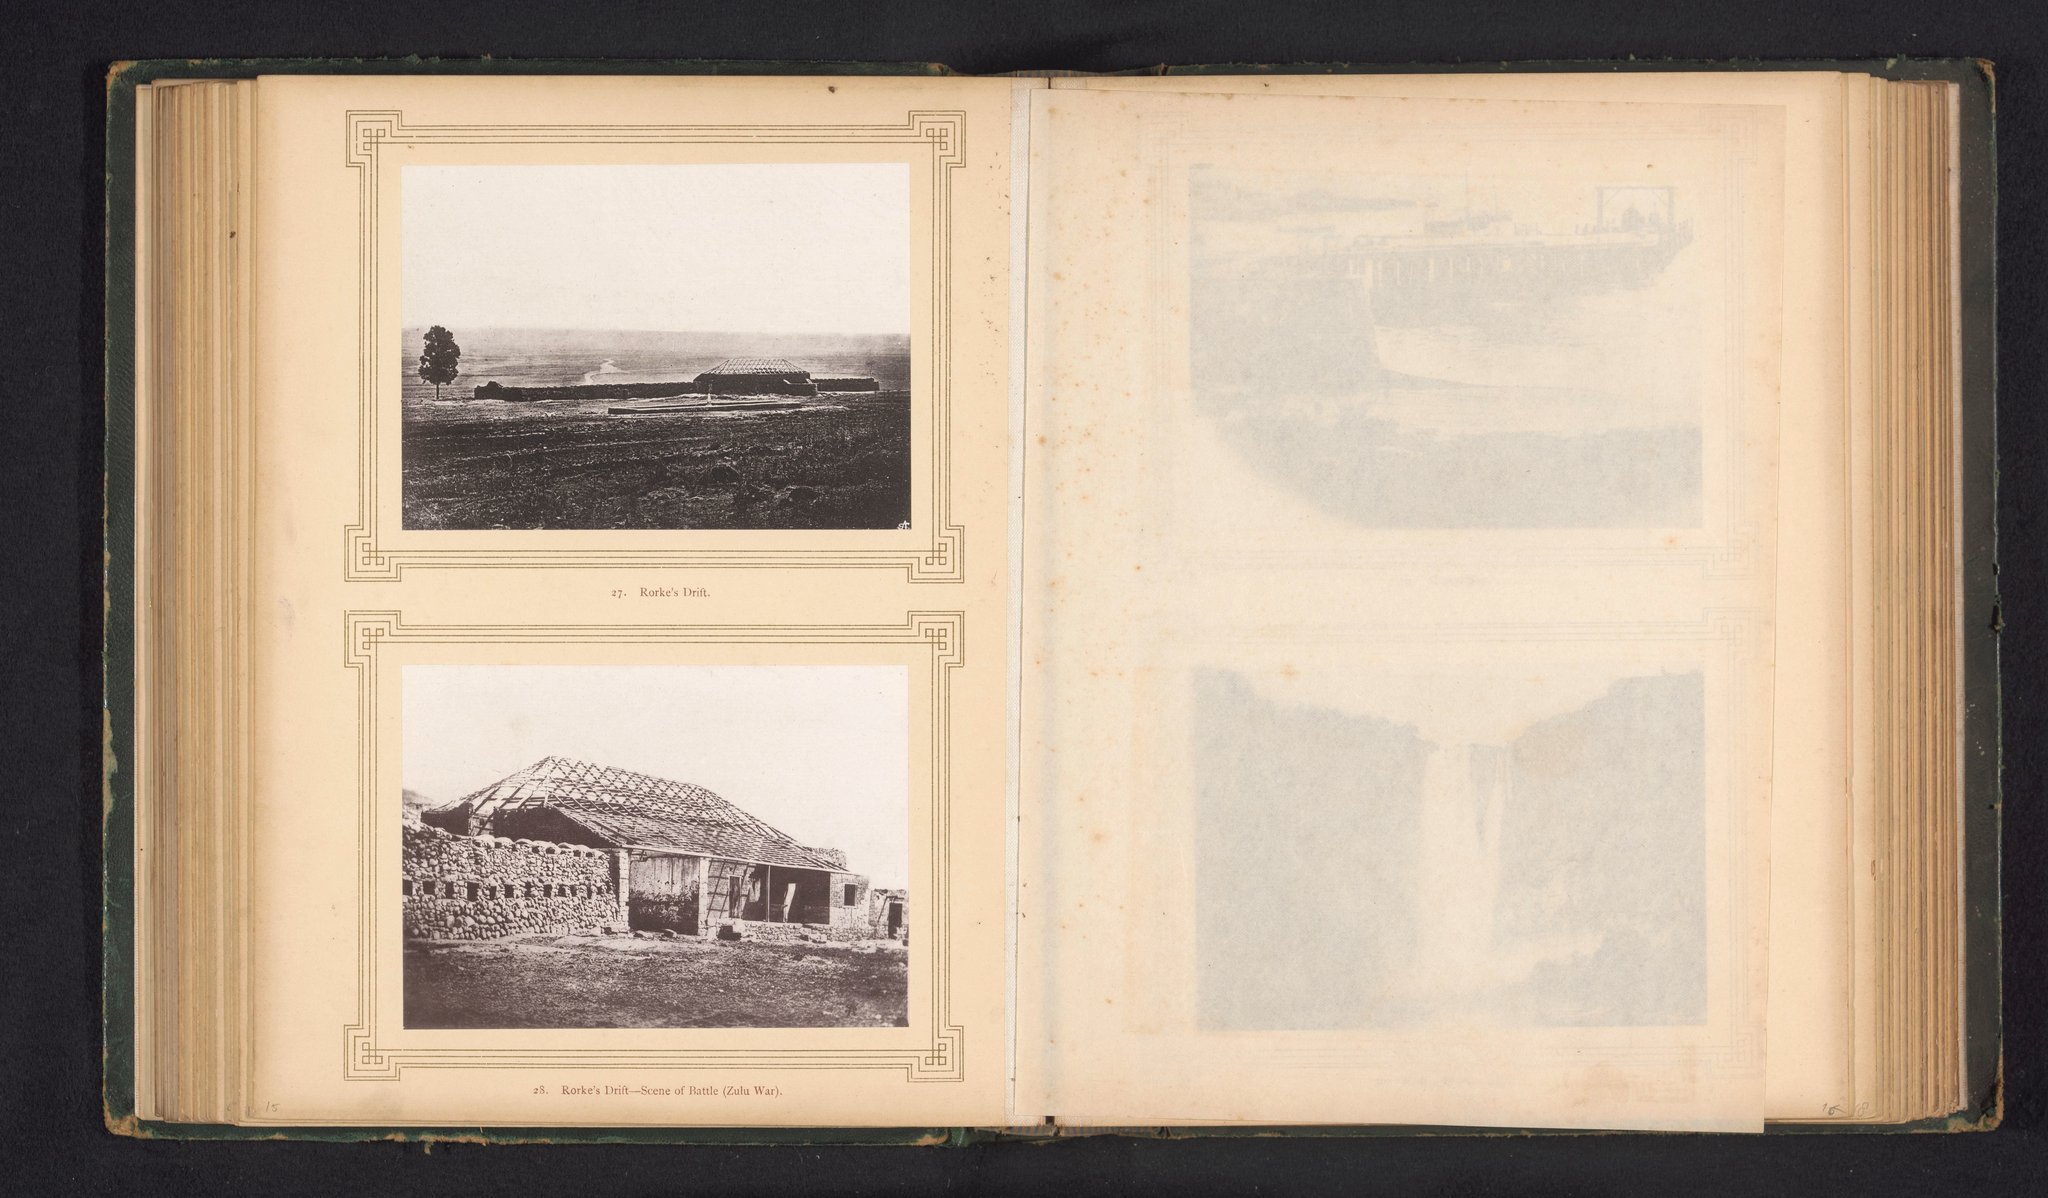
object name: page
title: Rorke's Drift - Scene of Battle (Zulu War)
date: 1870-1880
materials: paper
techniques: photograph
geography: zoeloeland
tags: battle, façade (of house or building), spreading the gospel; missionary work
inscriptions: inscription: ‘SA’, number: ‘27. 28.’